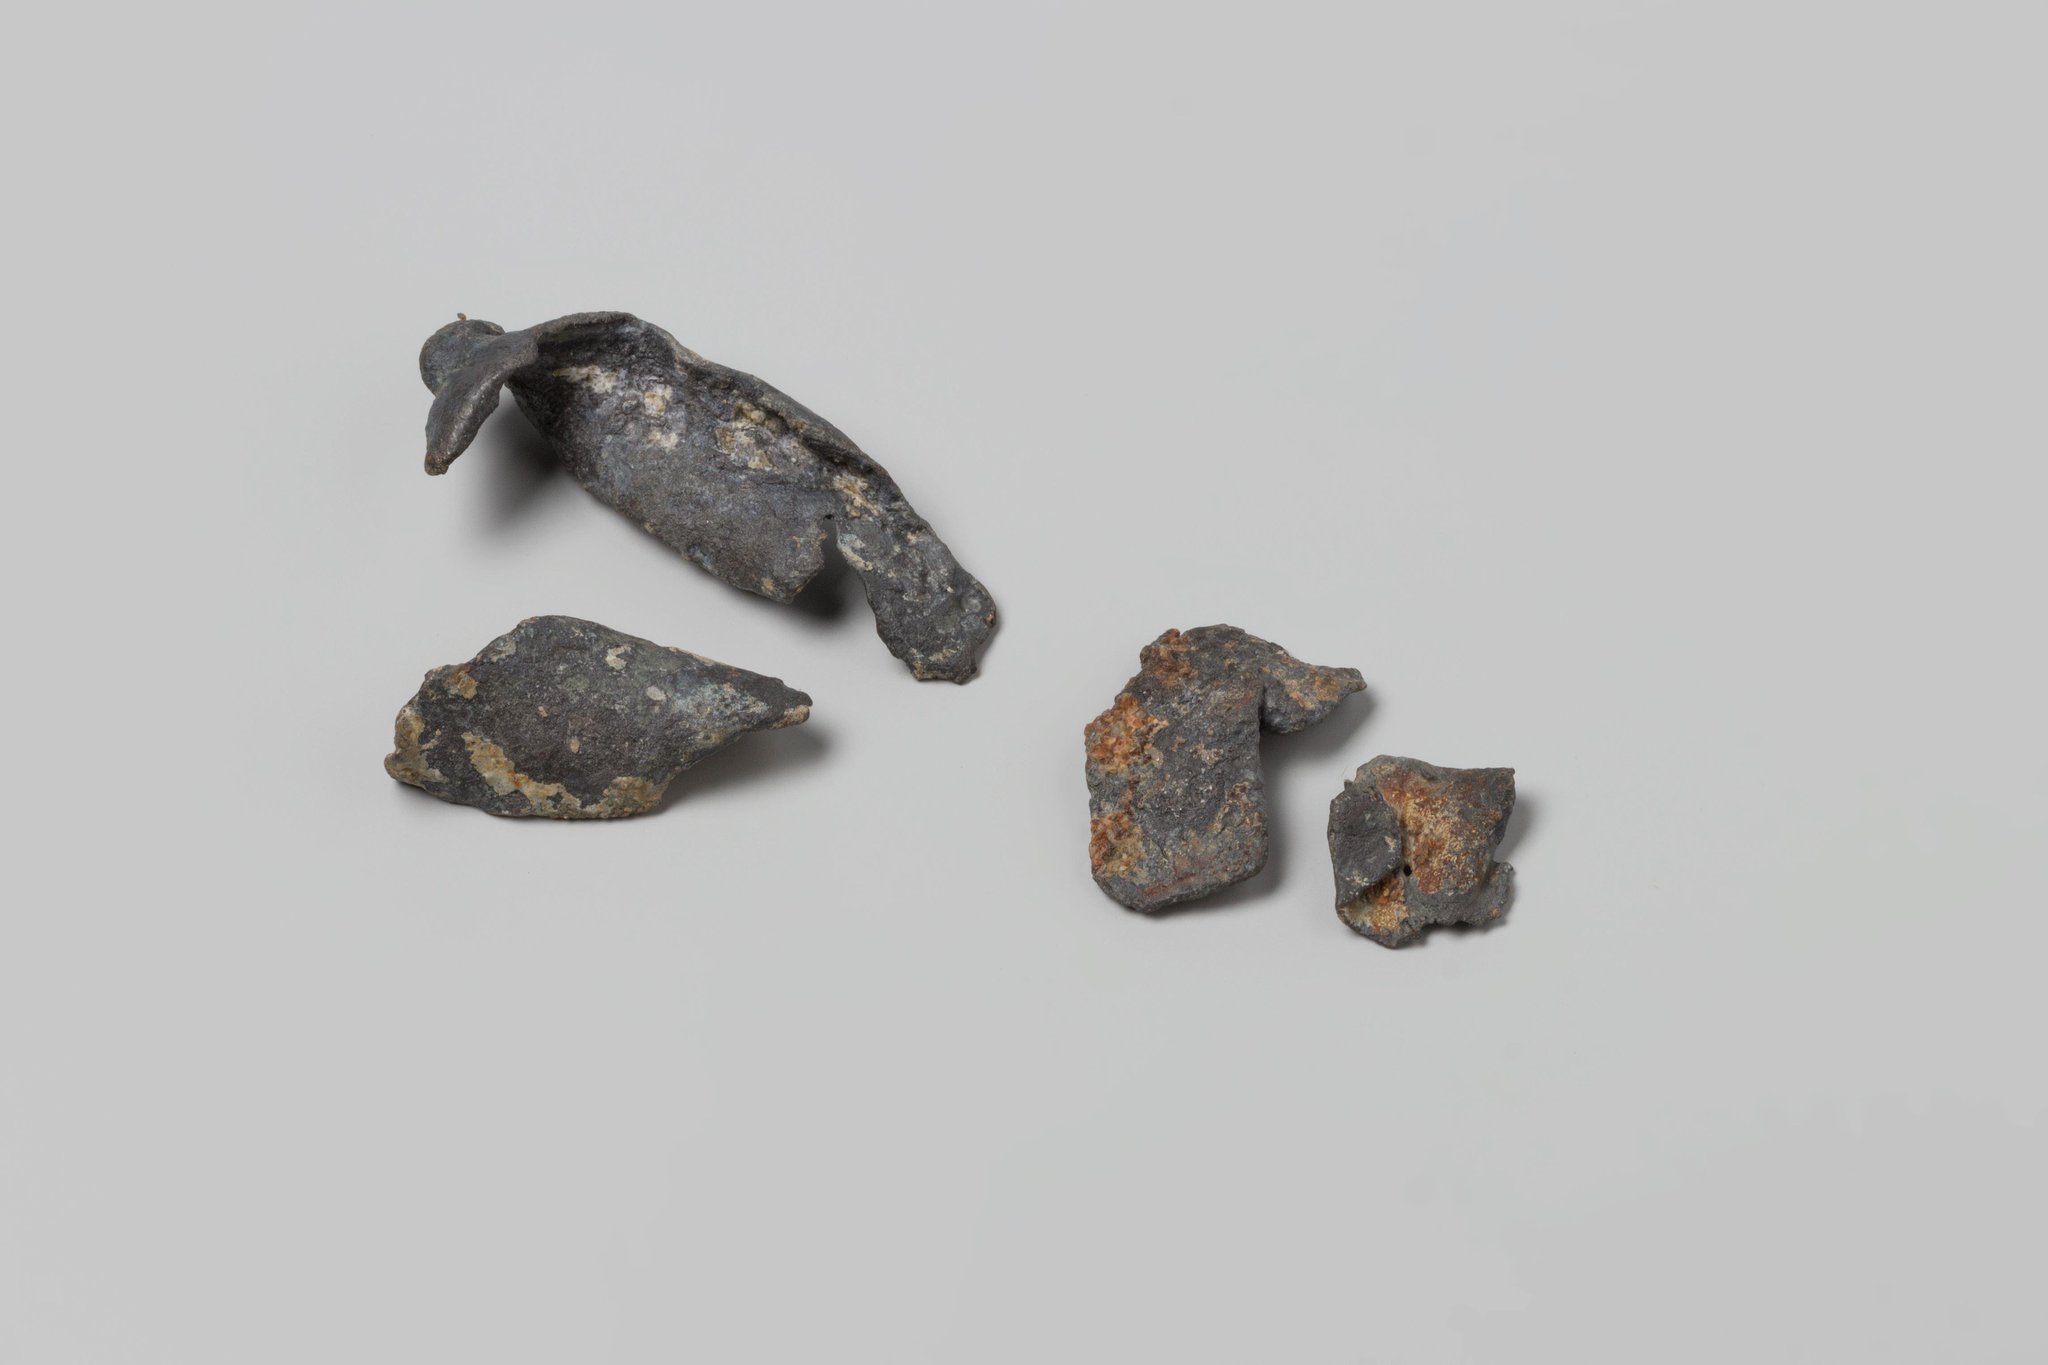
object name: fragment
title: Fragmenten lood uit het wrak van de Oost-Indiëvaarder Hollandia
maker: Anonymous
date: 1700-1743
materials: lead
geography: netherlands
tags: verenigde oostindische compagnie, hollandia (schip), annet